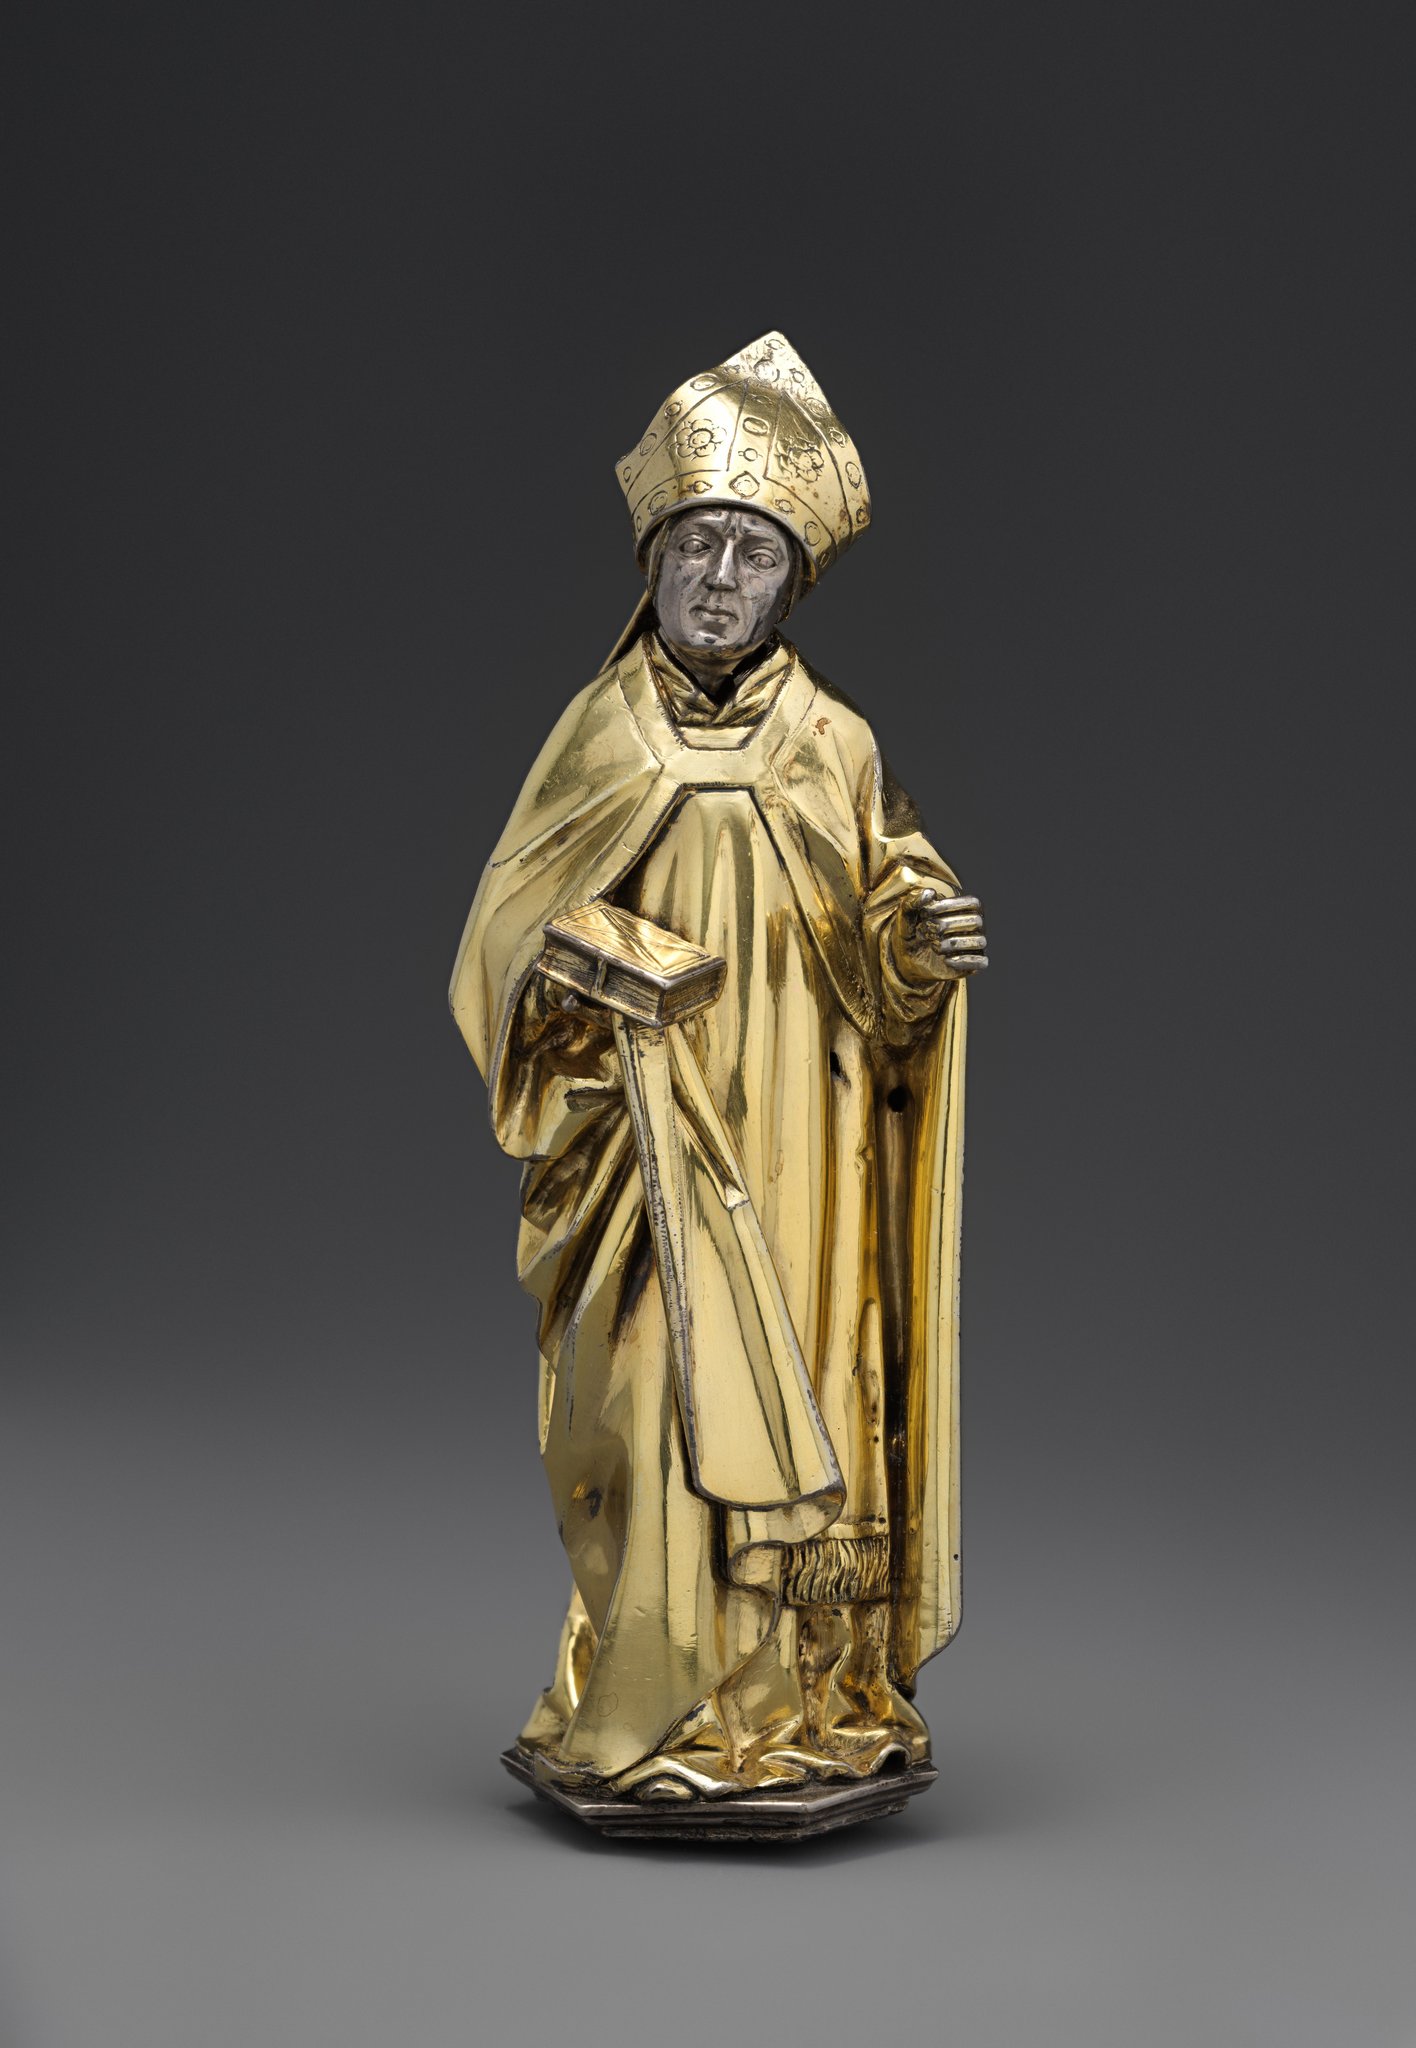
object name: statuette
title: Standing Bishop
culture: german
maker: hans von reutlingen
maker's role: artist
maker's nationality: german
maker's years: 1465-1547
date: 1510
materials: silver, silver gilt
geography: germany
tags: men,bishops